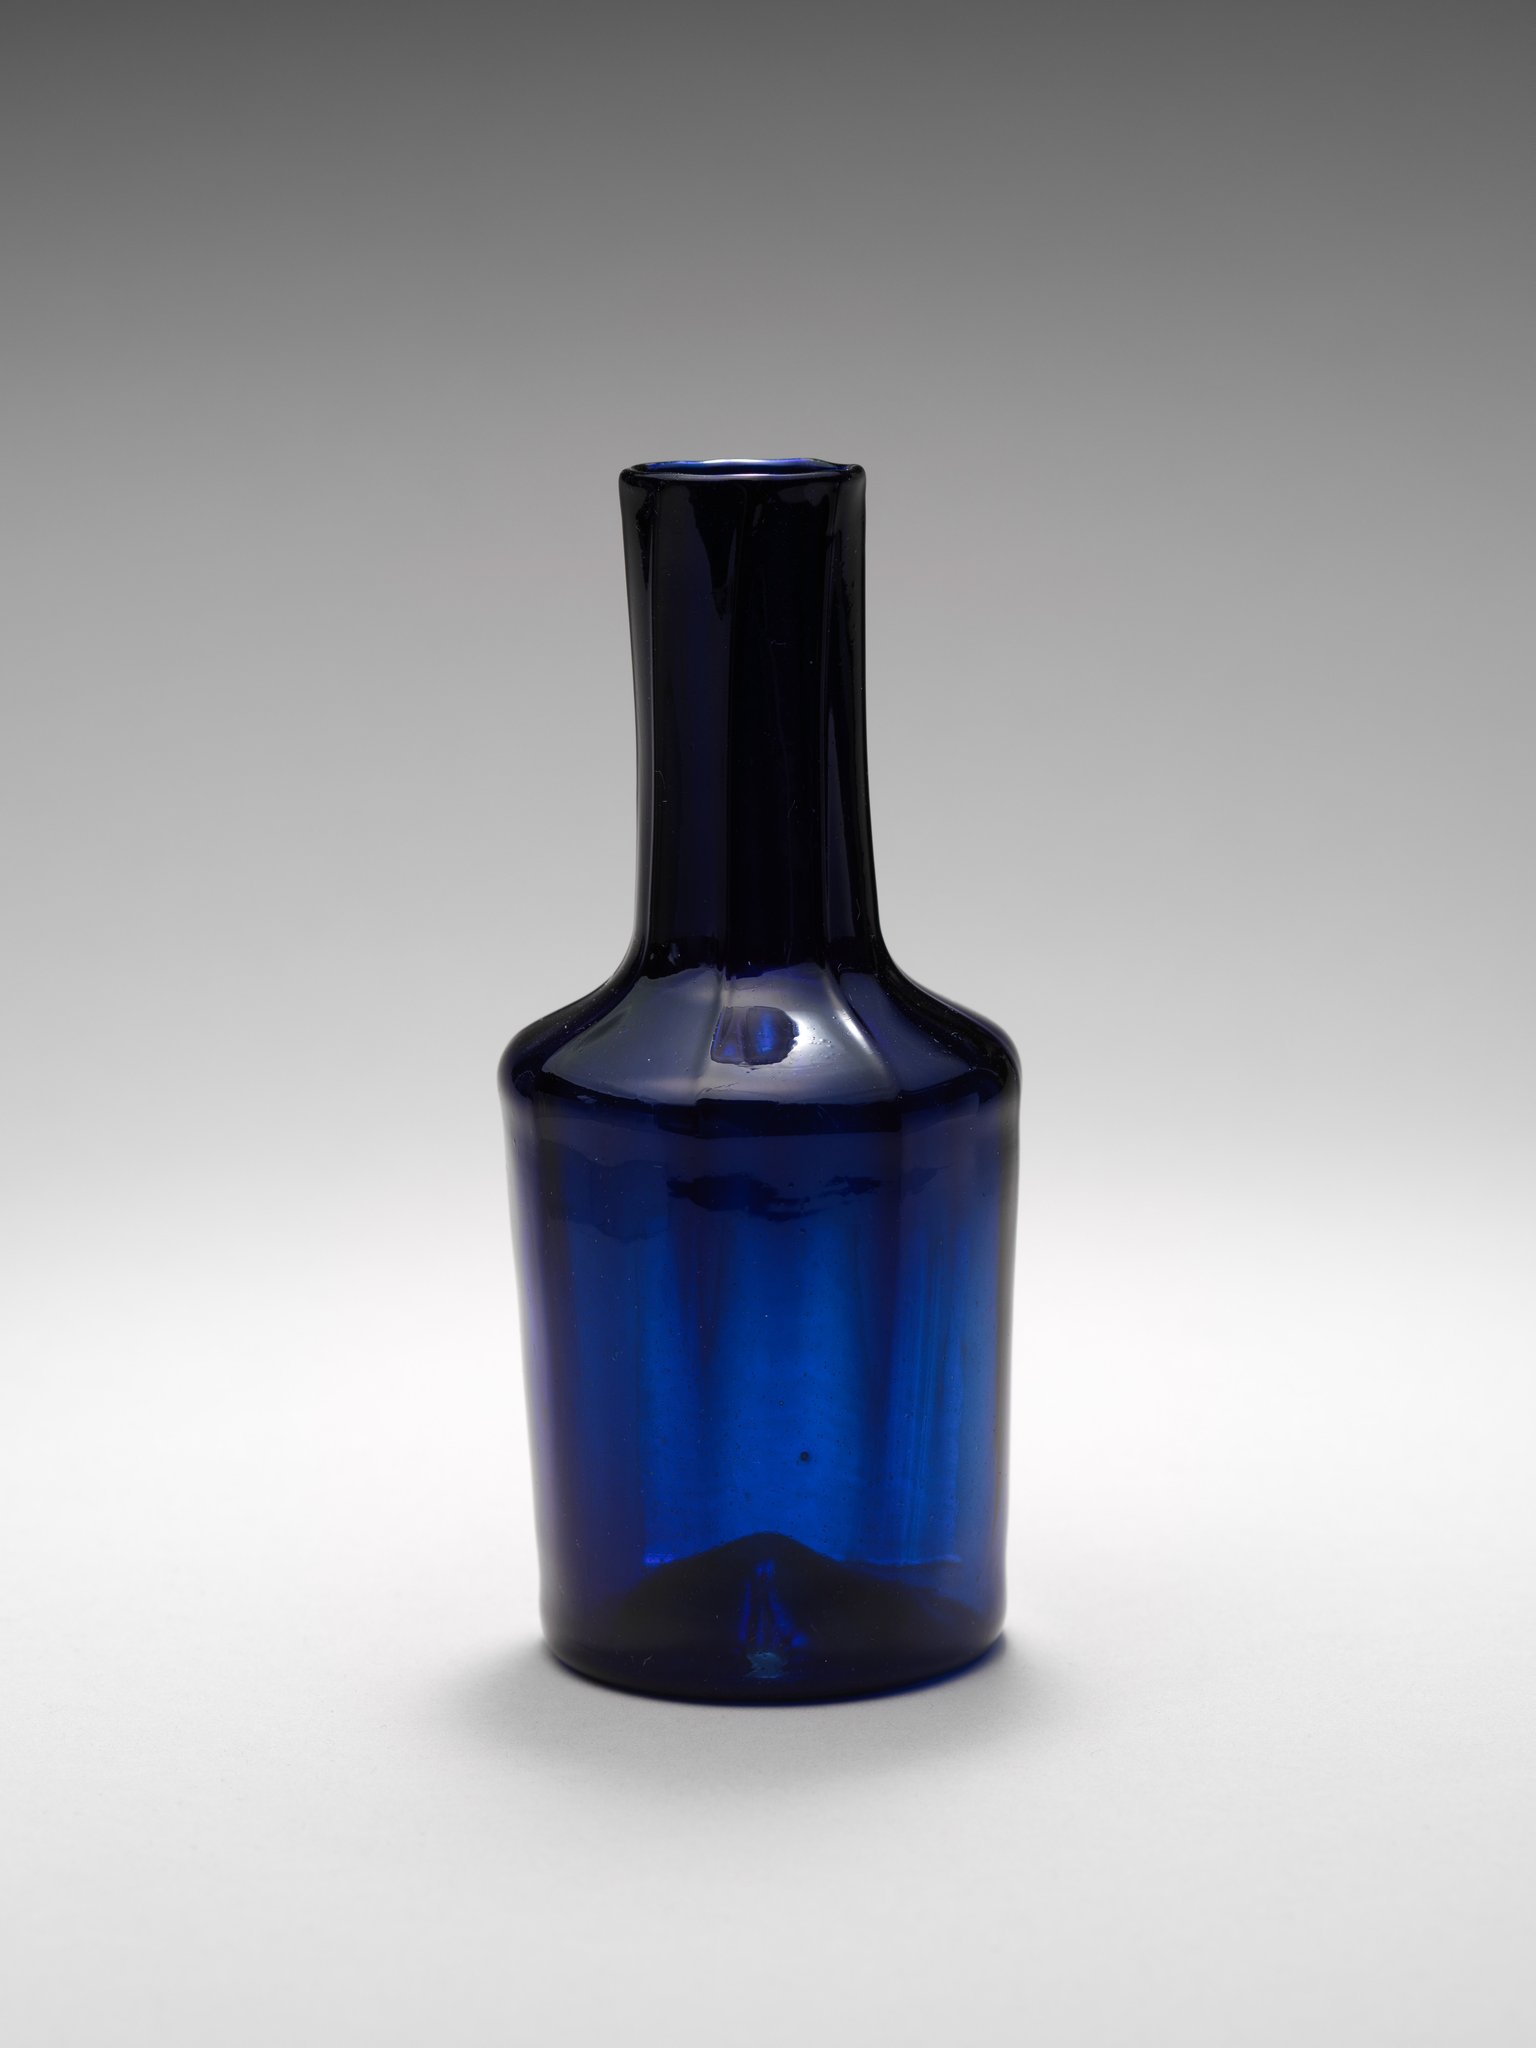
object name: bottle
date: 1701-1800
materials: glass